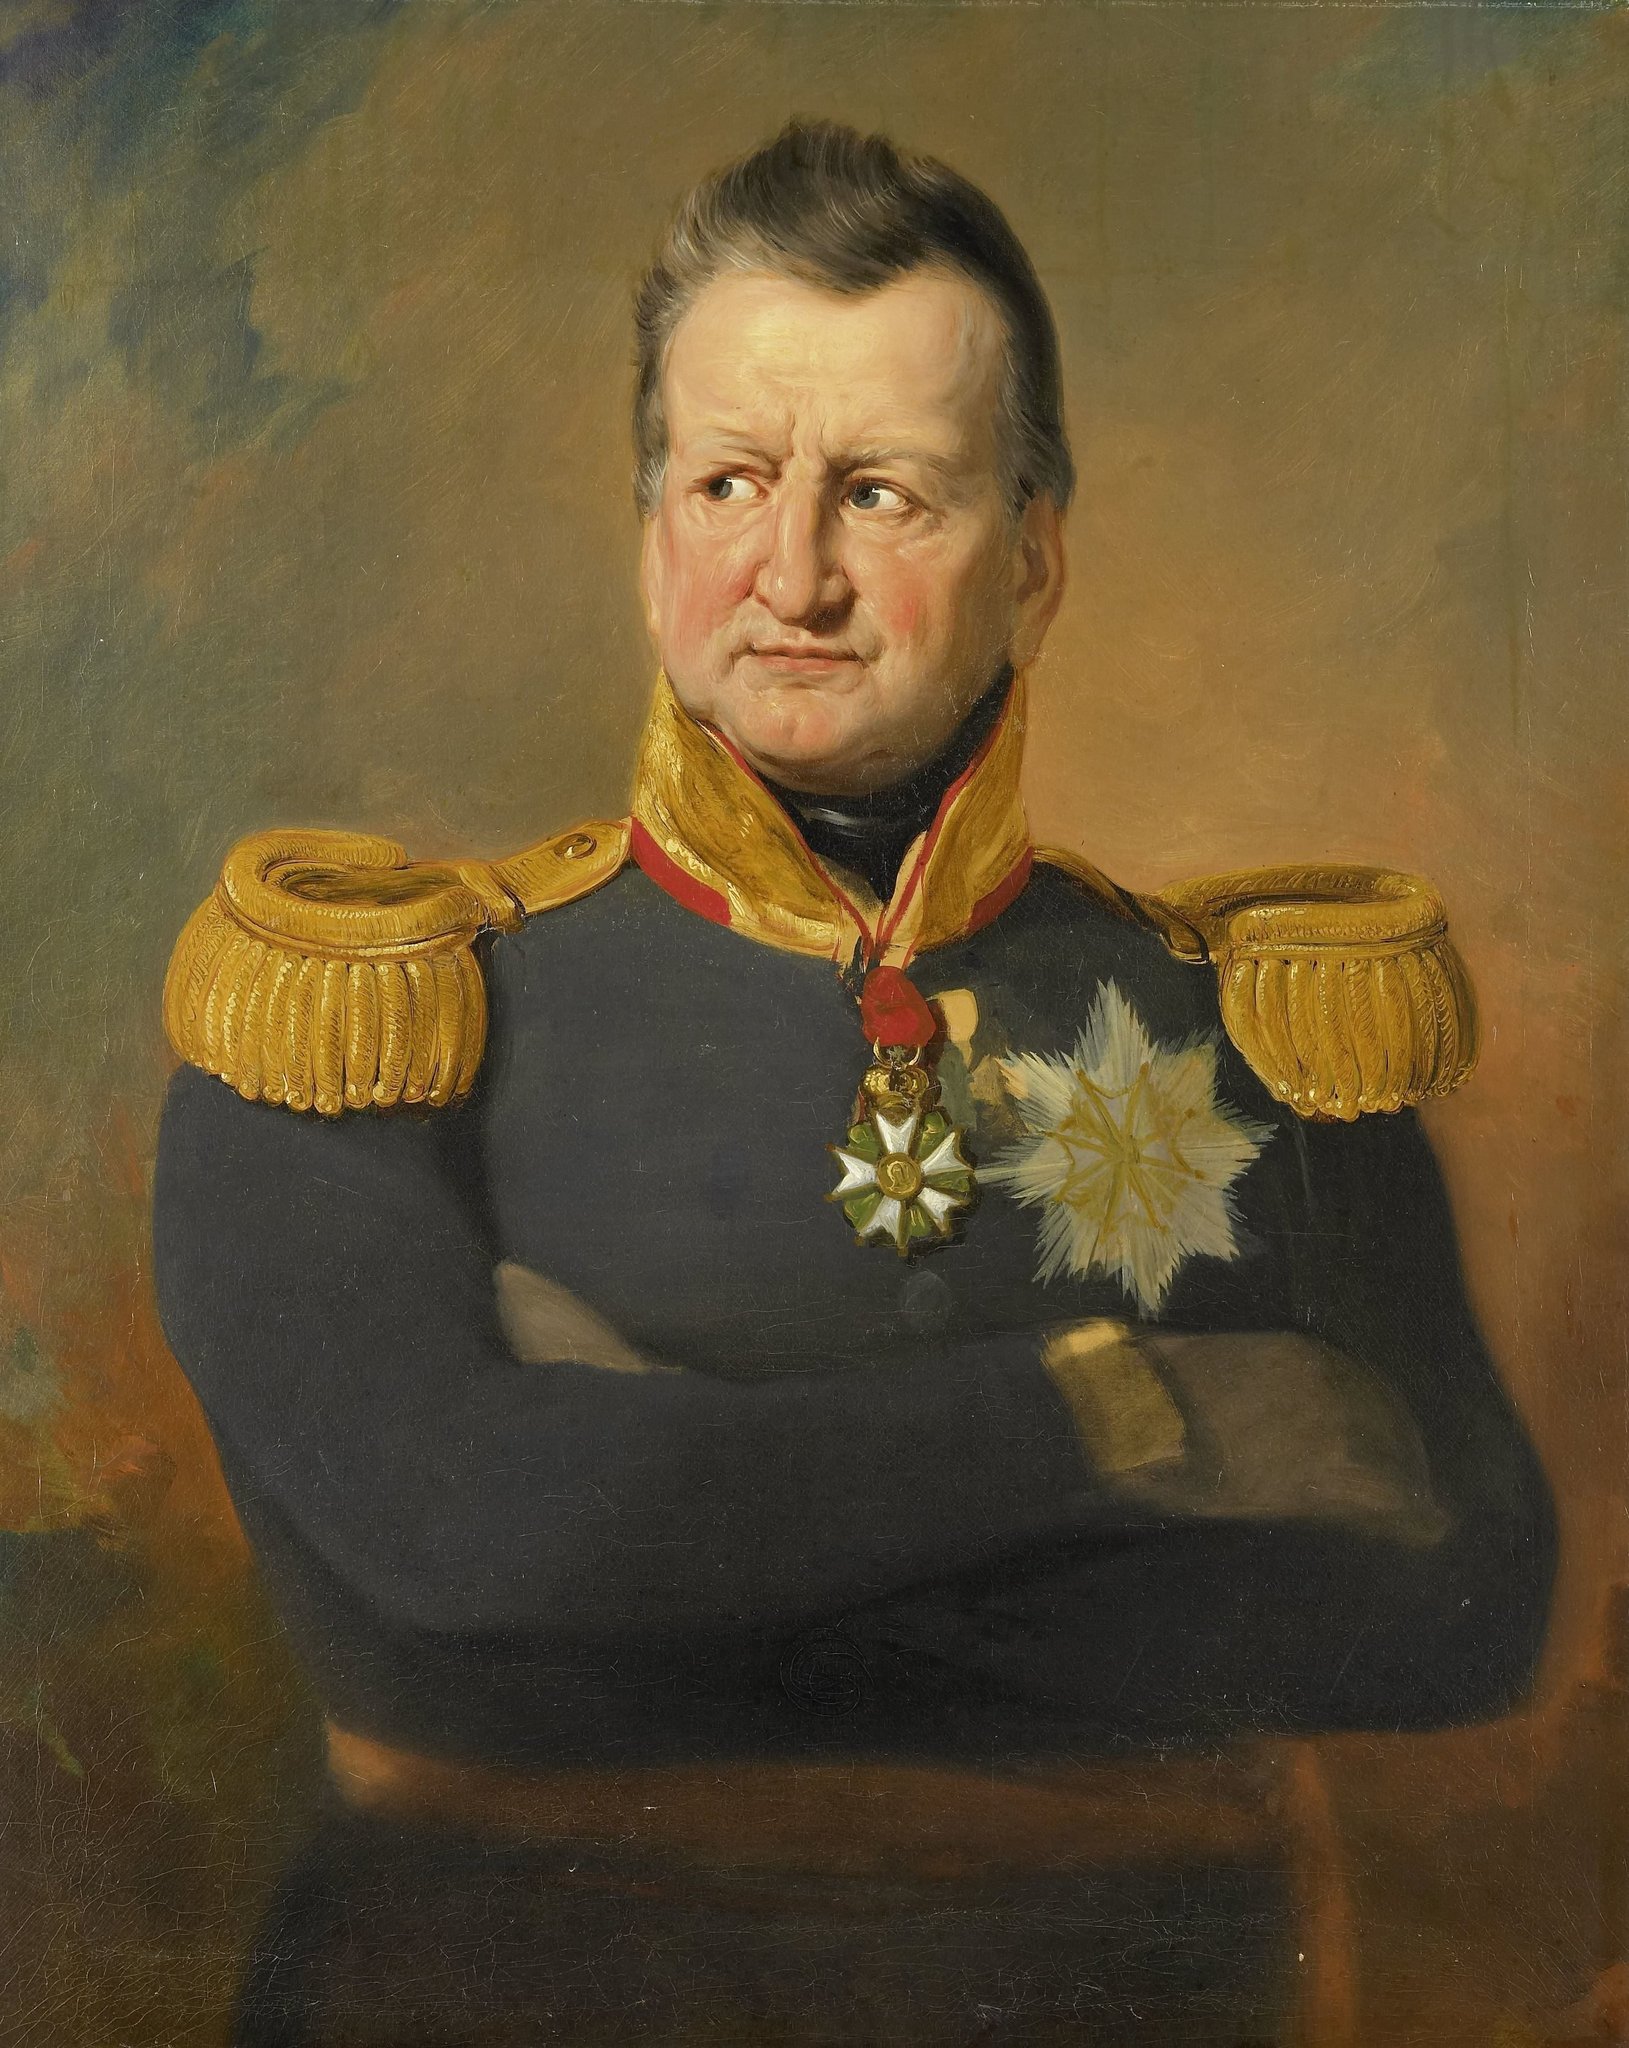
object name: painting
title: Portrait of Baron David Hendrik Chassé, Lieutenant-General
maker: jan willem pieneman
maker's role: draughtsman, painter, print maker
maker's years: 1779-1853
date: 1832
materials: canvas, oil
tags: david hendrik baron chassé, commander-in-chief, general, marshal, historical persons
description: Portret van David Hendrik baron Chassé (1765-1849), luitenant-generaal. Ten halven lijve in uniform, staande met de armen gevouwen voor de borst. Verdediger van de Citadel van Antwerpen (1832).